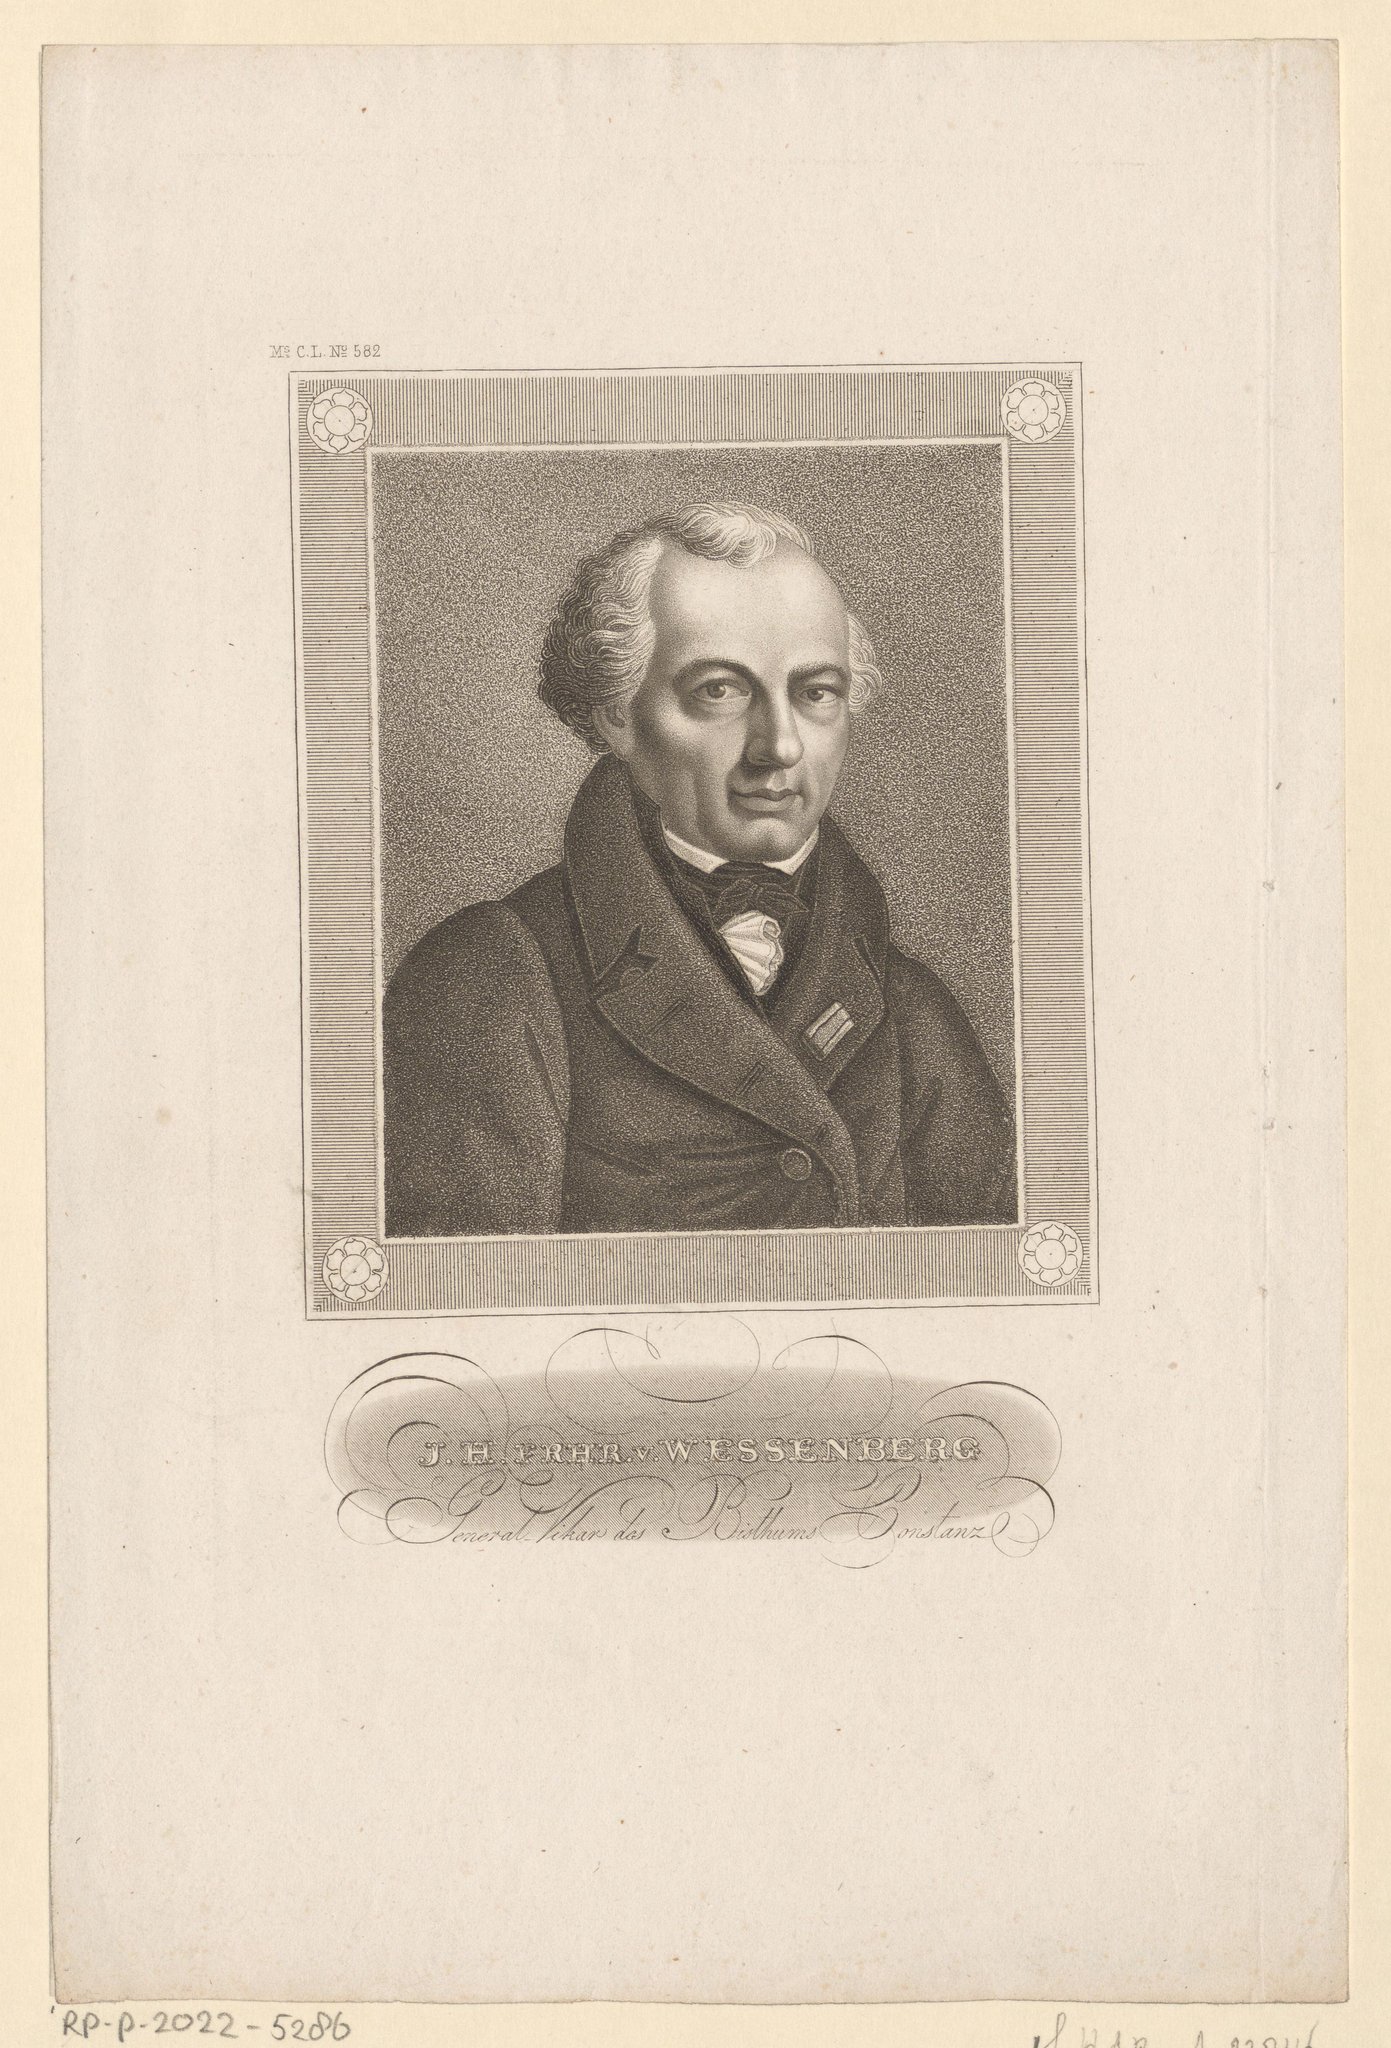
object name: book illustration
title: Portret van Ignaz Heinrich von Wessenberg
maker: Anonymous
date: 1840-1855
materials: paper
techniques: etching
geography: hildburghausen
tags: theologian, historical persons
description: Prent uit: Meyer, Joseph. Conversations-Lexikon für die gebildeten Stände. Hildburghausen: Bibliographisches Institut, 1840-1855.